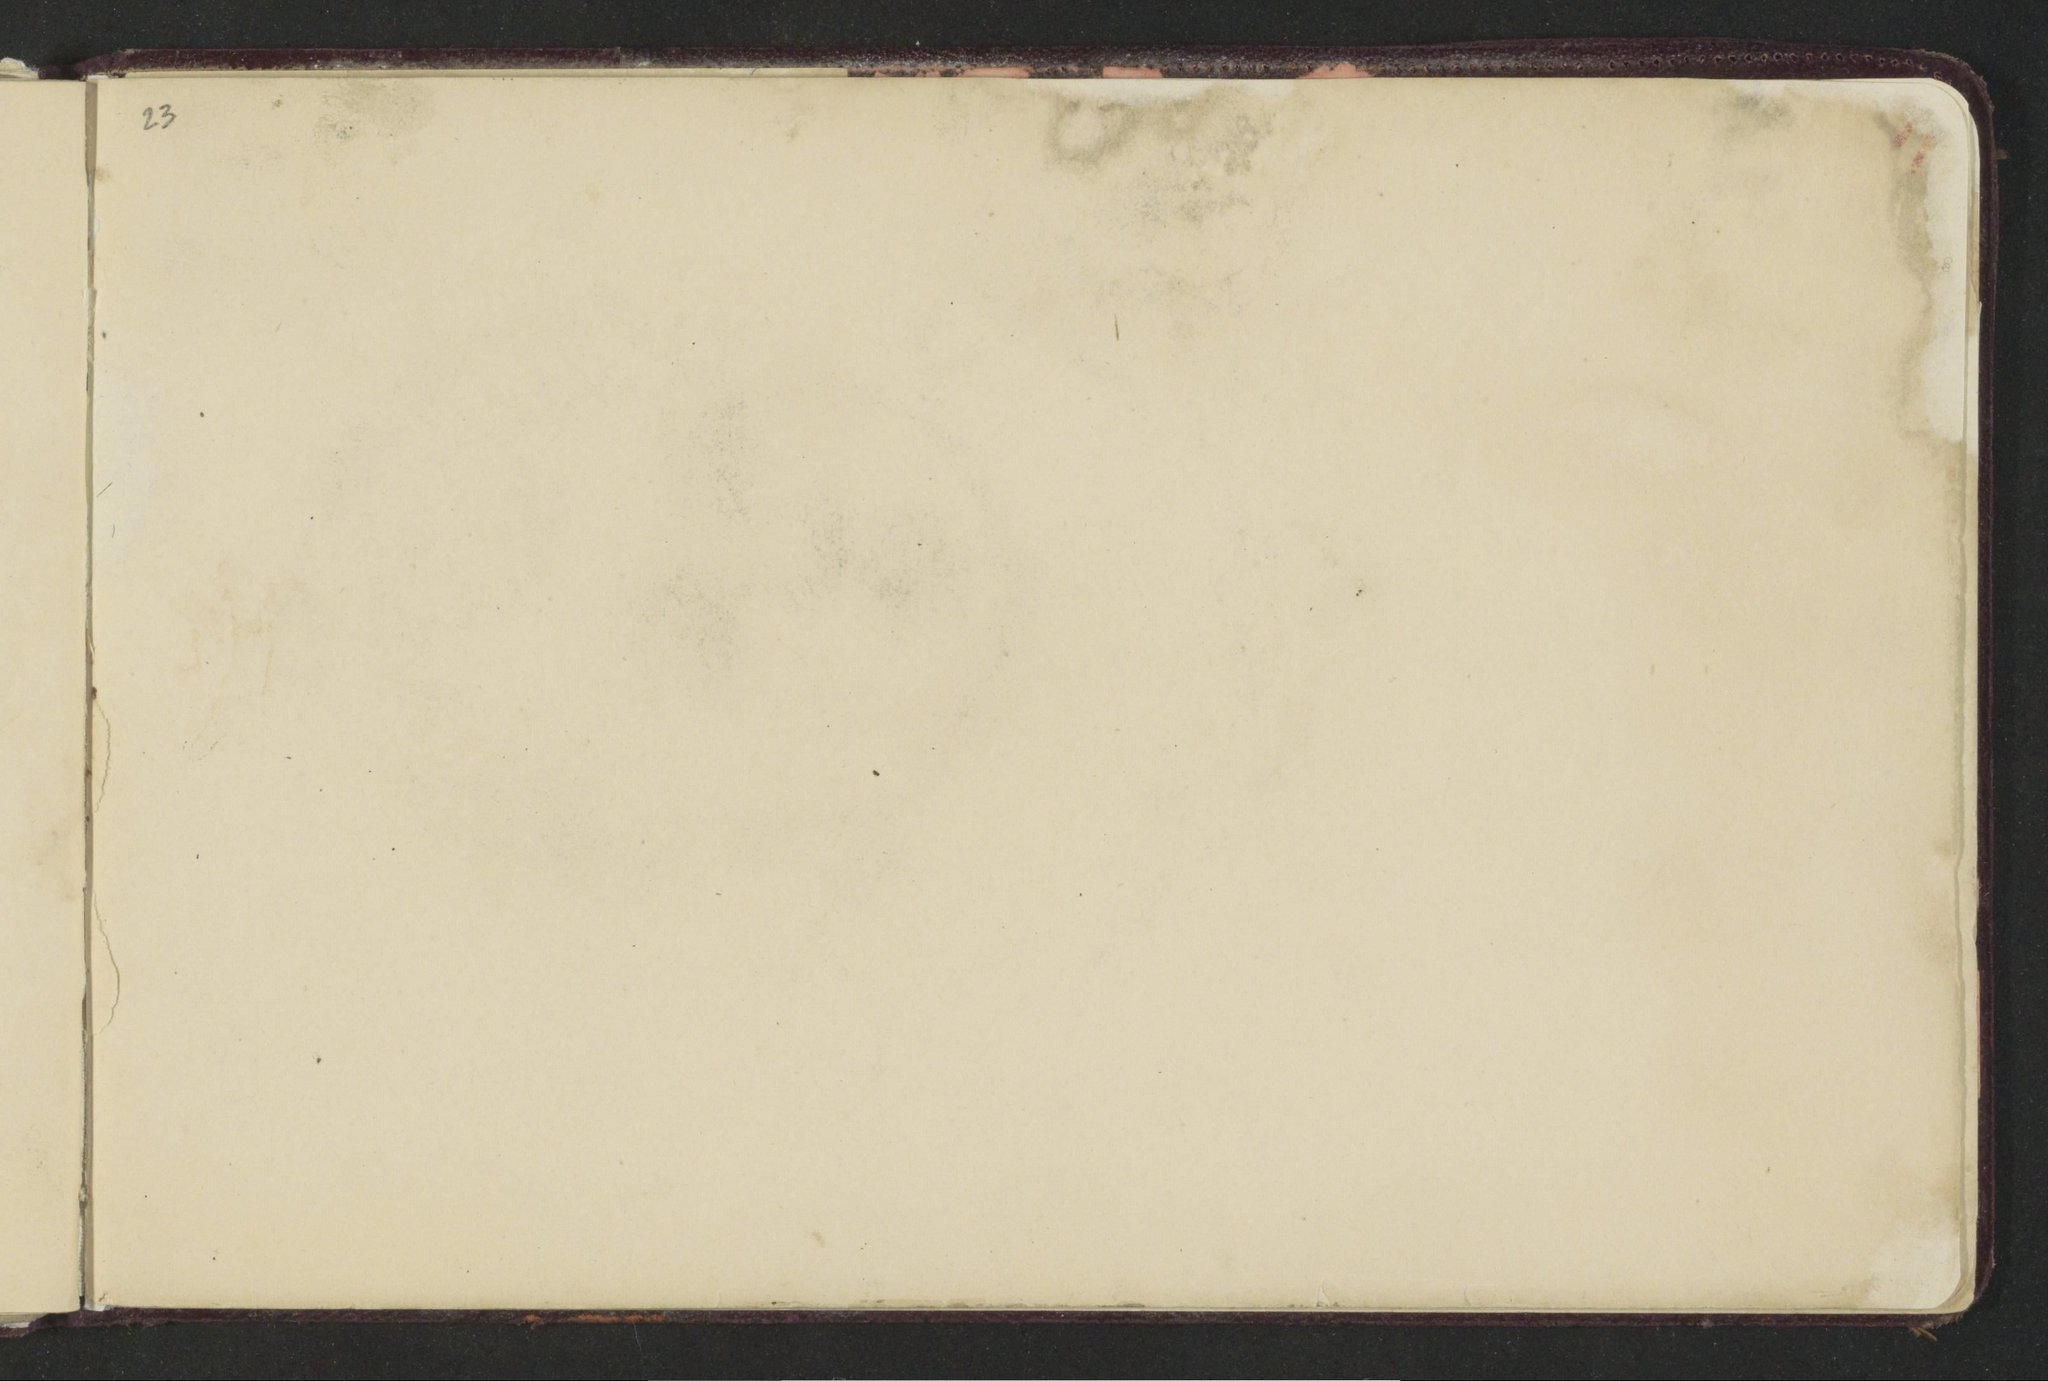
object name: sketchbook leaf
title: Abklatsch van een potloodtekening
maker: jozef israëls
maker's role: draughtsman, painter, print maker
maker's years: 1824-1911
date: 1885-1911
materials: paper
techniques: printmaking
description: De tekening van een kop van een kind is niet langer aanwezig in het schetsboek. Blad 23 recto uit een schetsboek met 26 bladen.